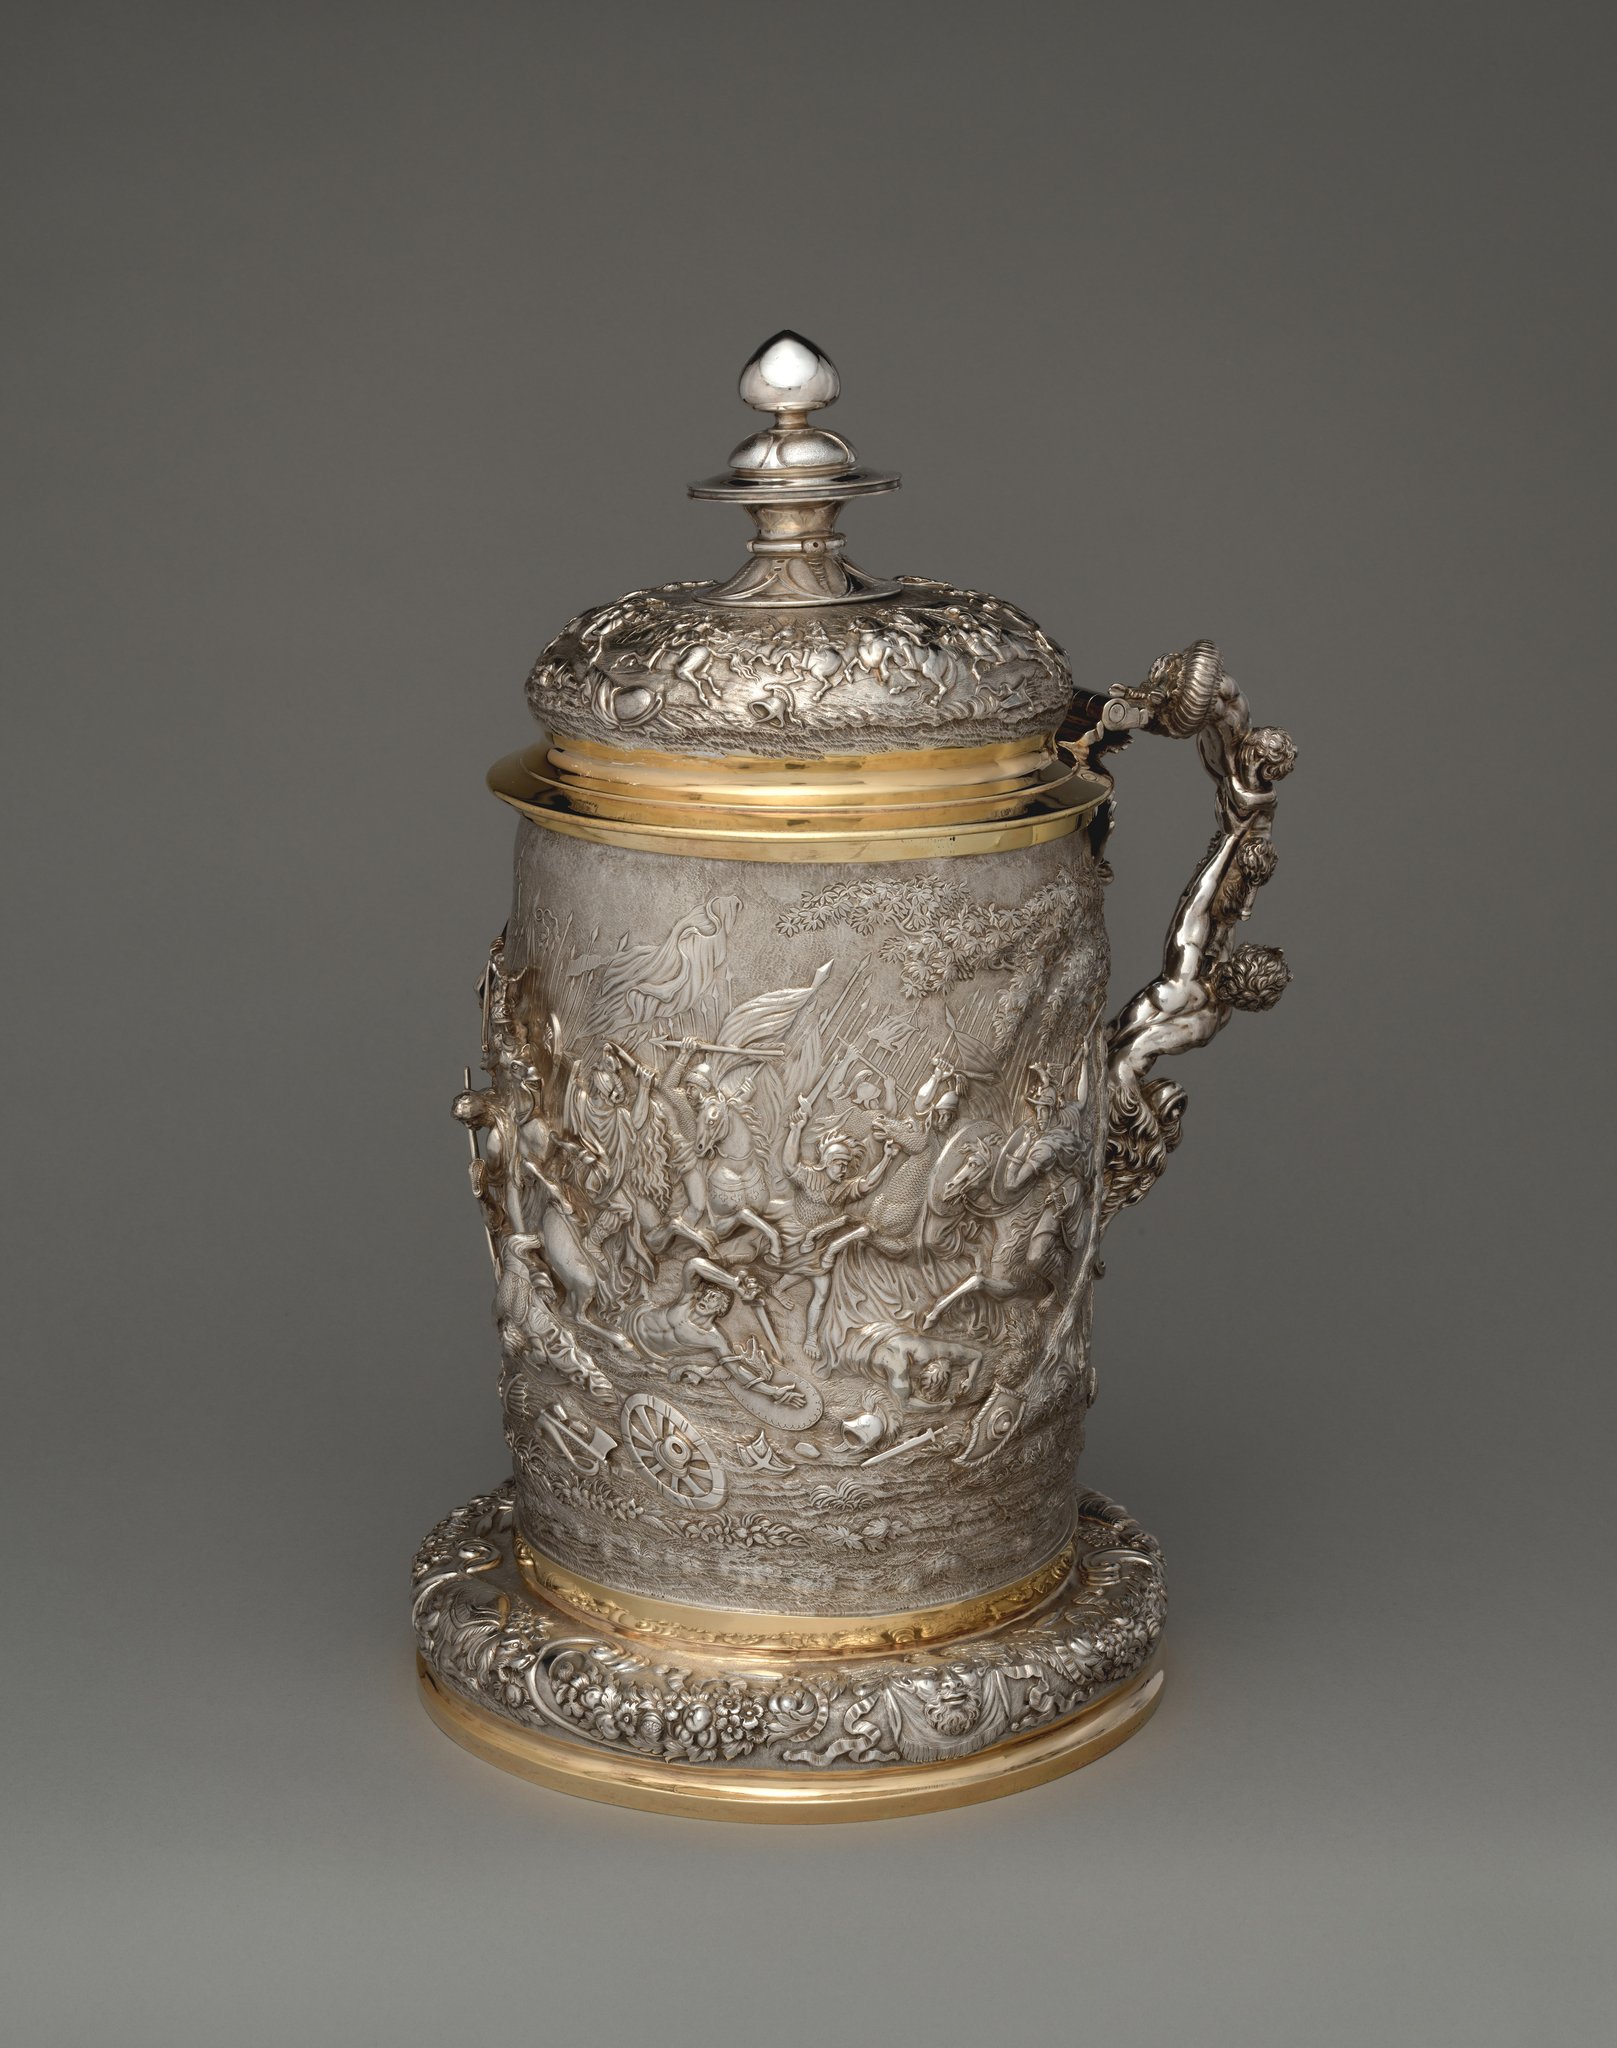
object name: tankard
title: Tankard (one of a pair)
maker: edward farrell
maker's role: silversmith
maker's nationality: british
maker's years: 1779-1850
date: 1824-1825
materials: gilt silver, silver